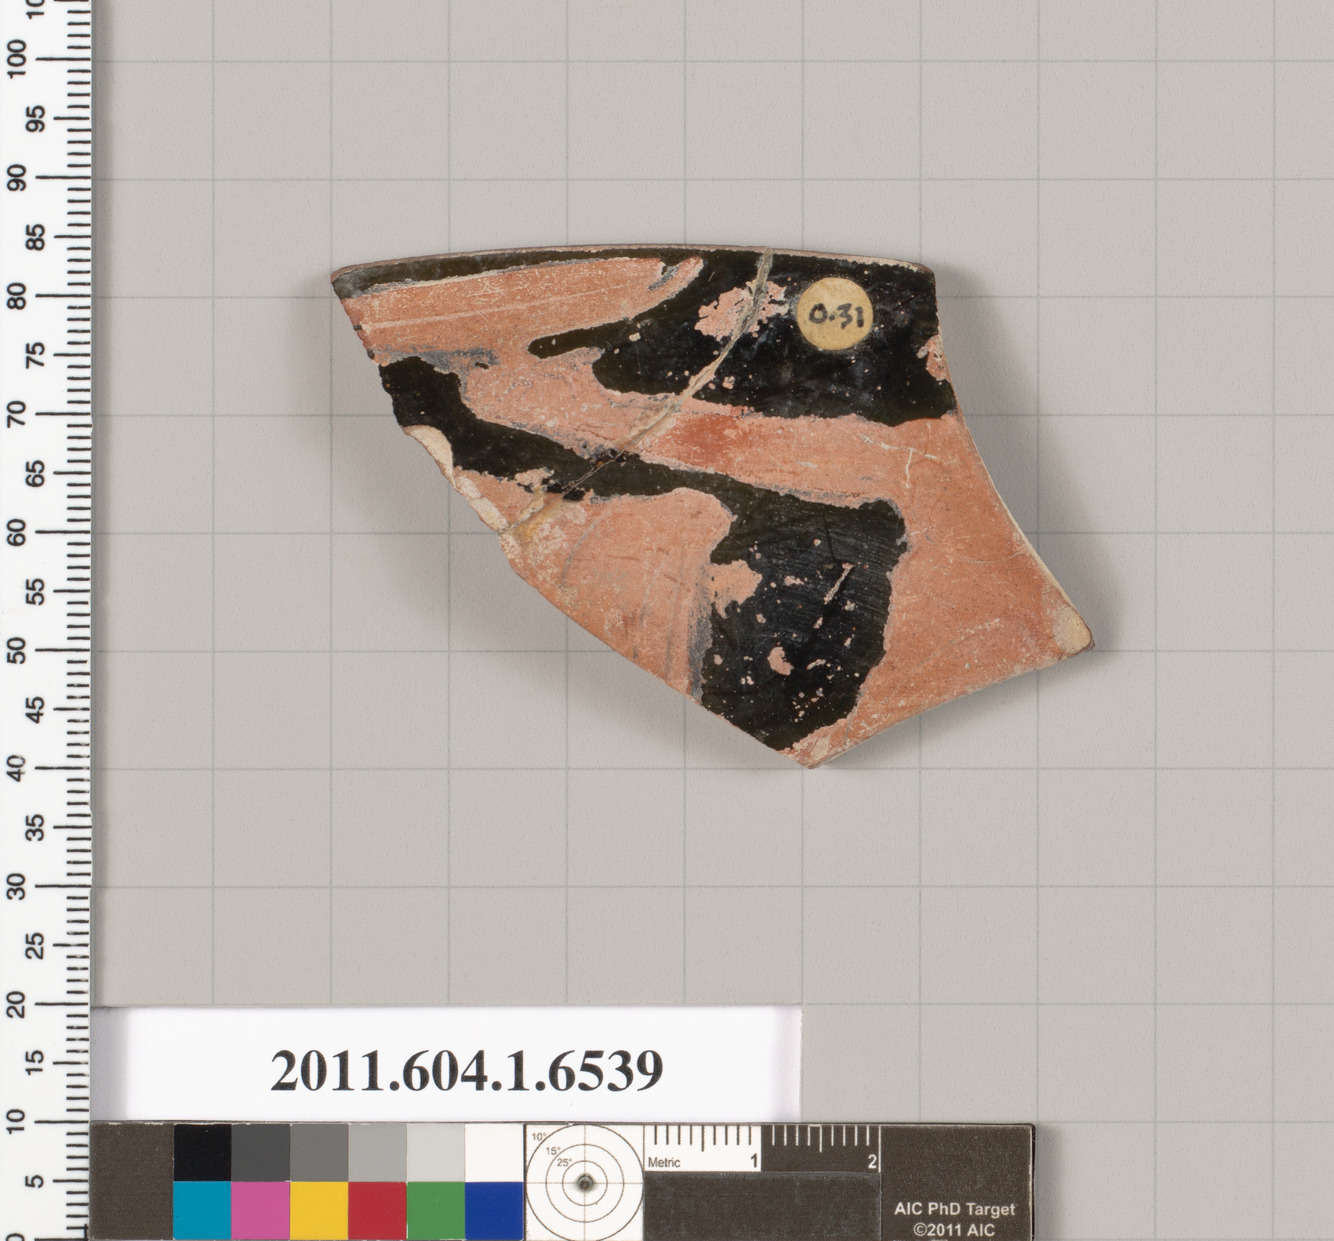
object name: kylix fragment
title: Terracotta rim fragment of a kylix (drinking cup)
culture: greek, attic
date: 490-480 BCE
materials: terracotta